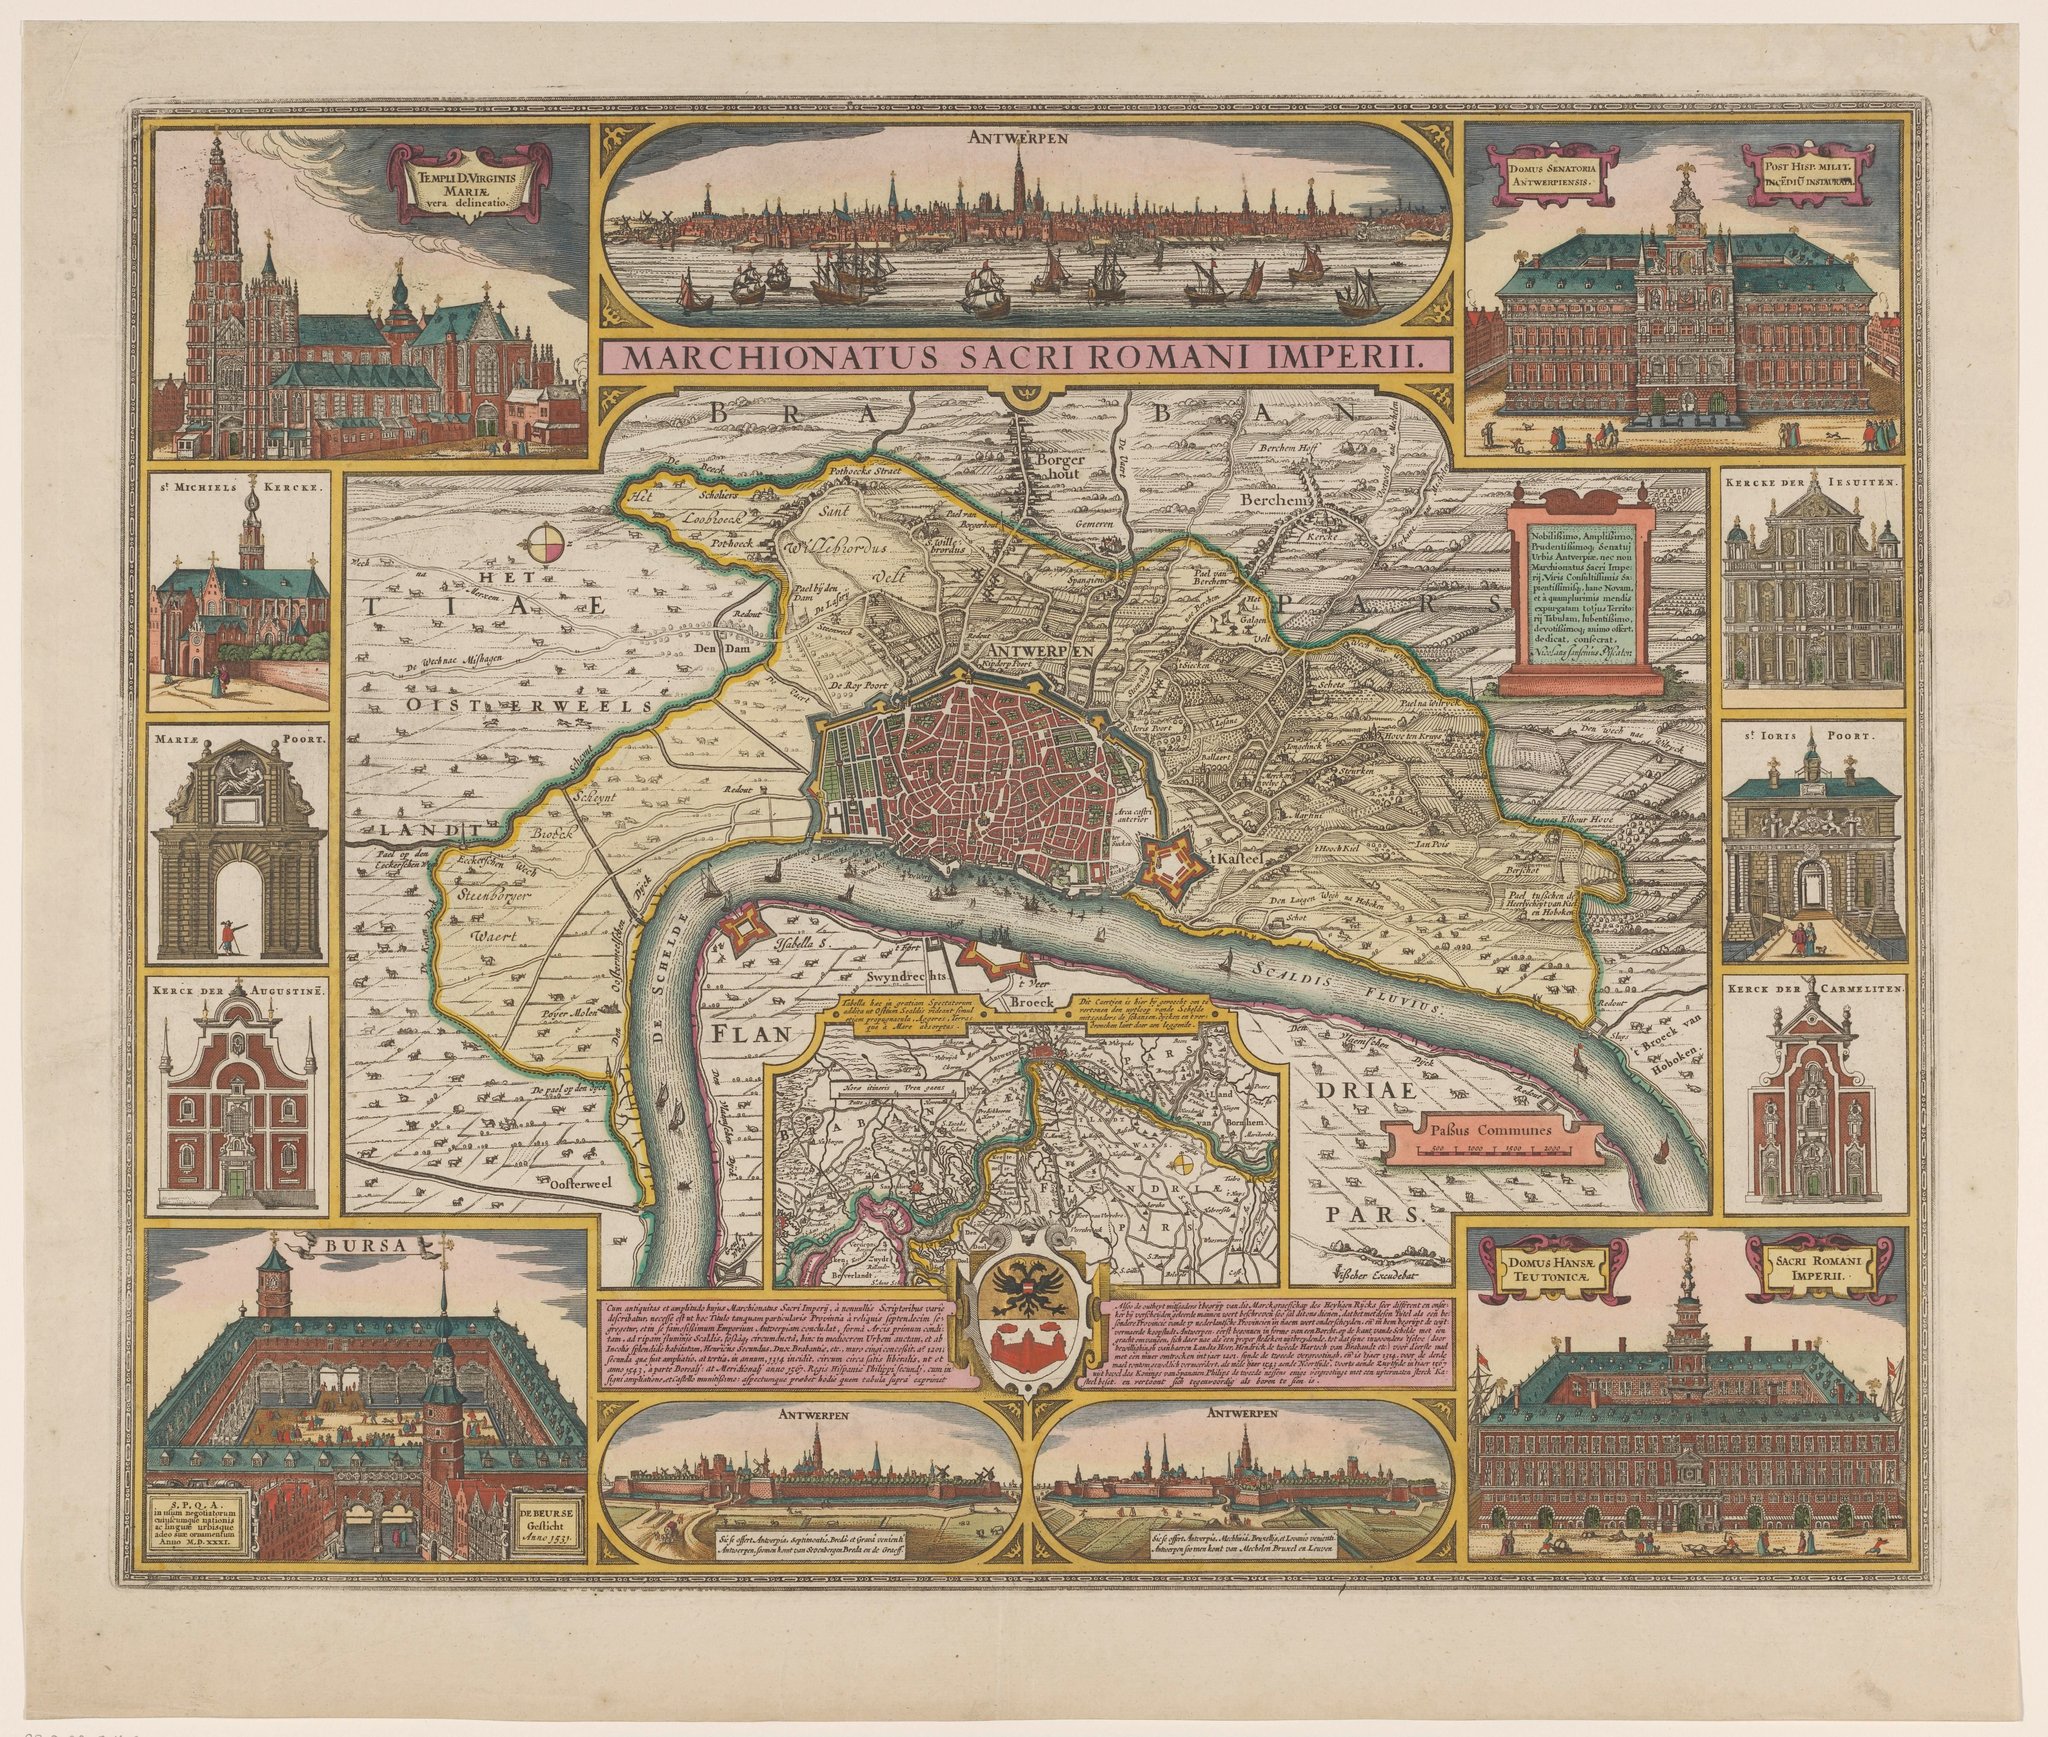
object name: map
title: Plattegrond van de stad Antwerpen en zijn omgeving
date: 1634-1720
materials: paper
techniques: engraving, etching, hand coloring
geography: amsterdam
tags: coat of arms (as symbol of the state, etc.) (+ city; municipal), maps of separate countries or regions, church (exterior), townhall, fortified city, maps of cities, city-gate, exchange, bourse, prospect of city, town panorama, silhouette of city, armorial bearing, heraldry, antwerp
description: Plattegrond van de stad Antwerpen en zijn omgeving. Rechtsonder een cartouche met schaalstok: 2000 Passus Communes. Onder, in het midden, een inzet met een kaart van het verloop van de Schelde. Onder de inzet het wapen van Antwerpen, met links Latijnse, en rechts Nederlandse tekst. Boven, in het midden, een gezicht op Antwerpen vanaf de Schelde gezien. Onder, links van het midden, een gezicht op Antwerpen vanuit de richting van Zevenbergen en Breda. Onder, rechts van het midden, een gezicht op Antwerpen vanuit de richting van Mechelen en Brussel. Langs de linkerkant van de kaart, van boven naar beneden, gezichten op de Onze-Lieve-Vrouwekathedraal, de Sint-Michielsabdij, de Mariapoort, de Sint-Augustinuskerk en de Handelsbeurs, te Antwerpen. Langs de rechterkant van de kaart, van boven naar beneden, gezichten op het Stadhuis, de Sint-Carolus Borromeuskerk, de Sint-Jorispoort, de Onze-Lieve-Vrouwebroederskerk en het Oosterhuis, te Antwerpen.